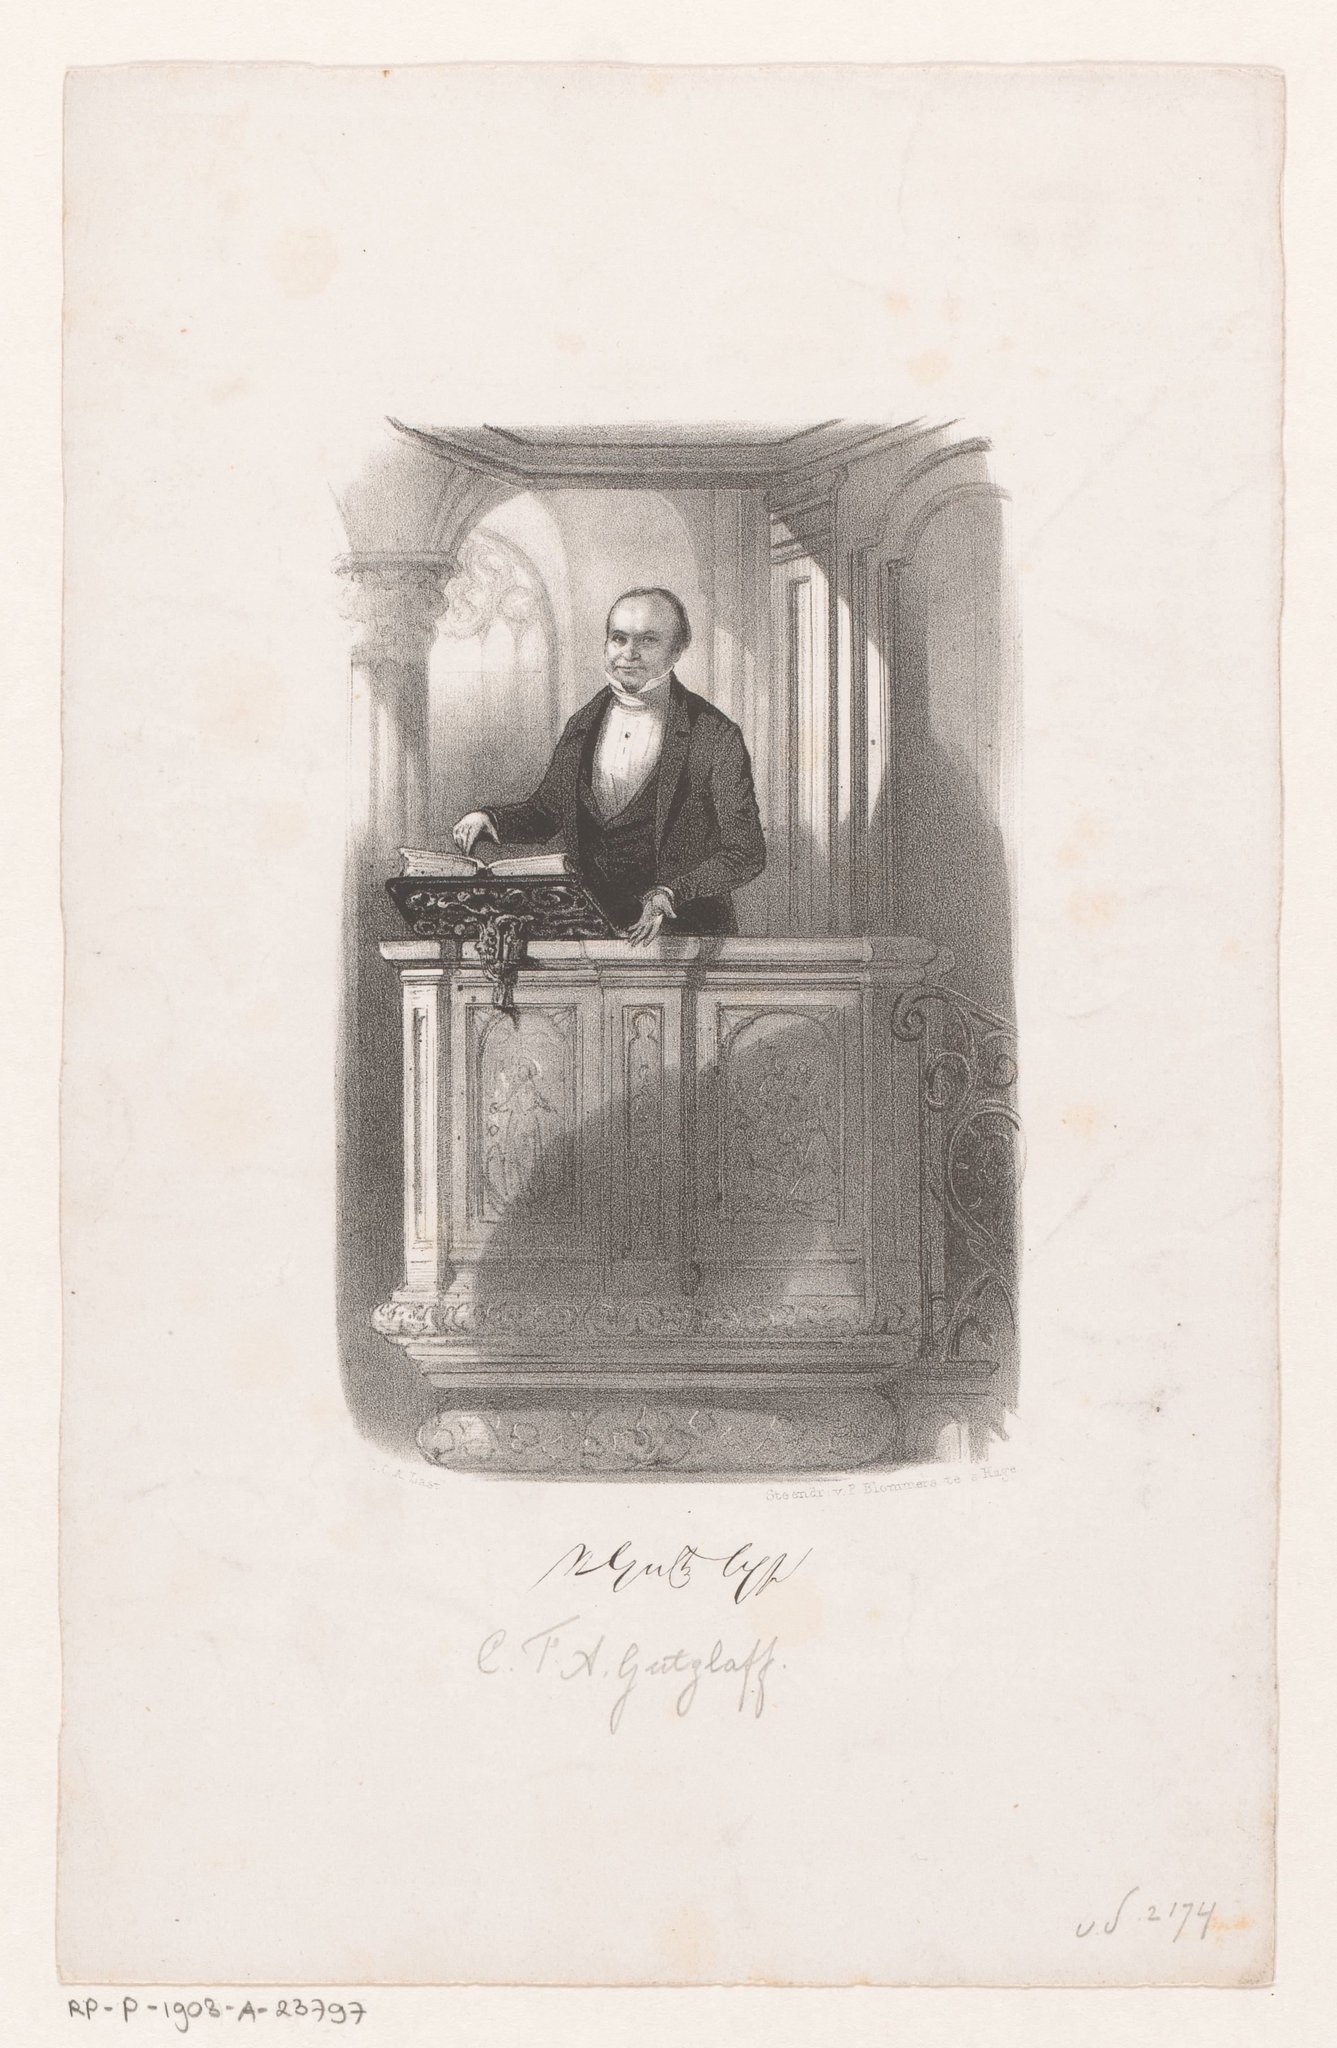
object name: print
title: Portret van Karl Friedrich August Gützlaff op een preekstoel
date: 1842-1887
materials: paper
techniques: lithograph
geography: netherlands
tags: reading the bible or other religious books, pulpit, ambo, chancel, historical persons (+ half-length portrait)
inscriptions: collector's mark: Lugt 2228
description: De geportretteerde staat in een kansel en wijst op een opengeslagen Bijbel.